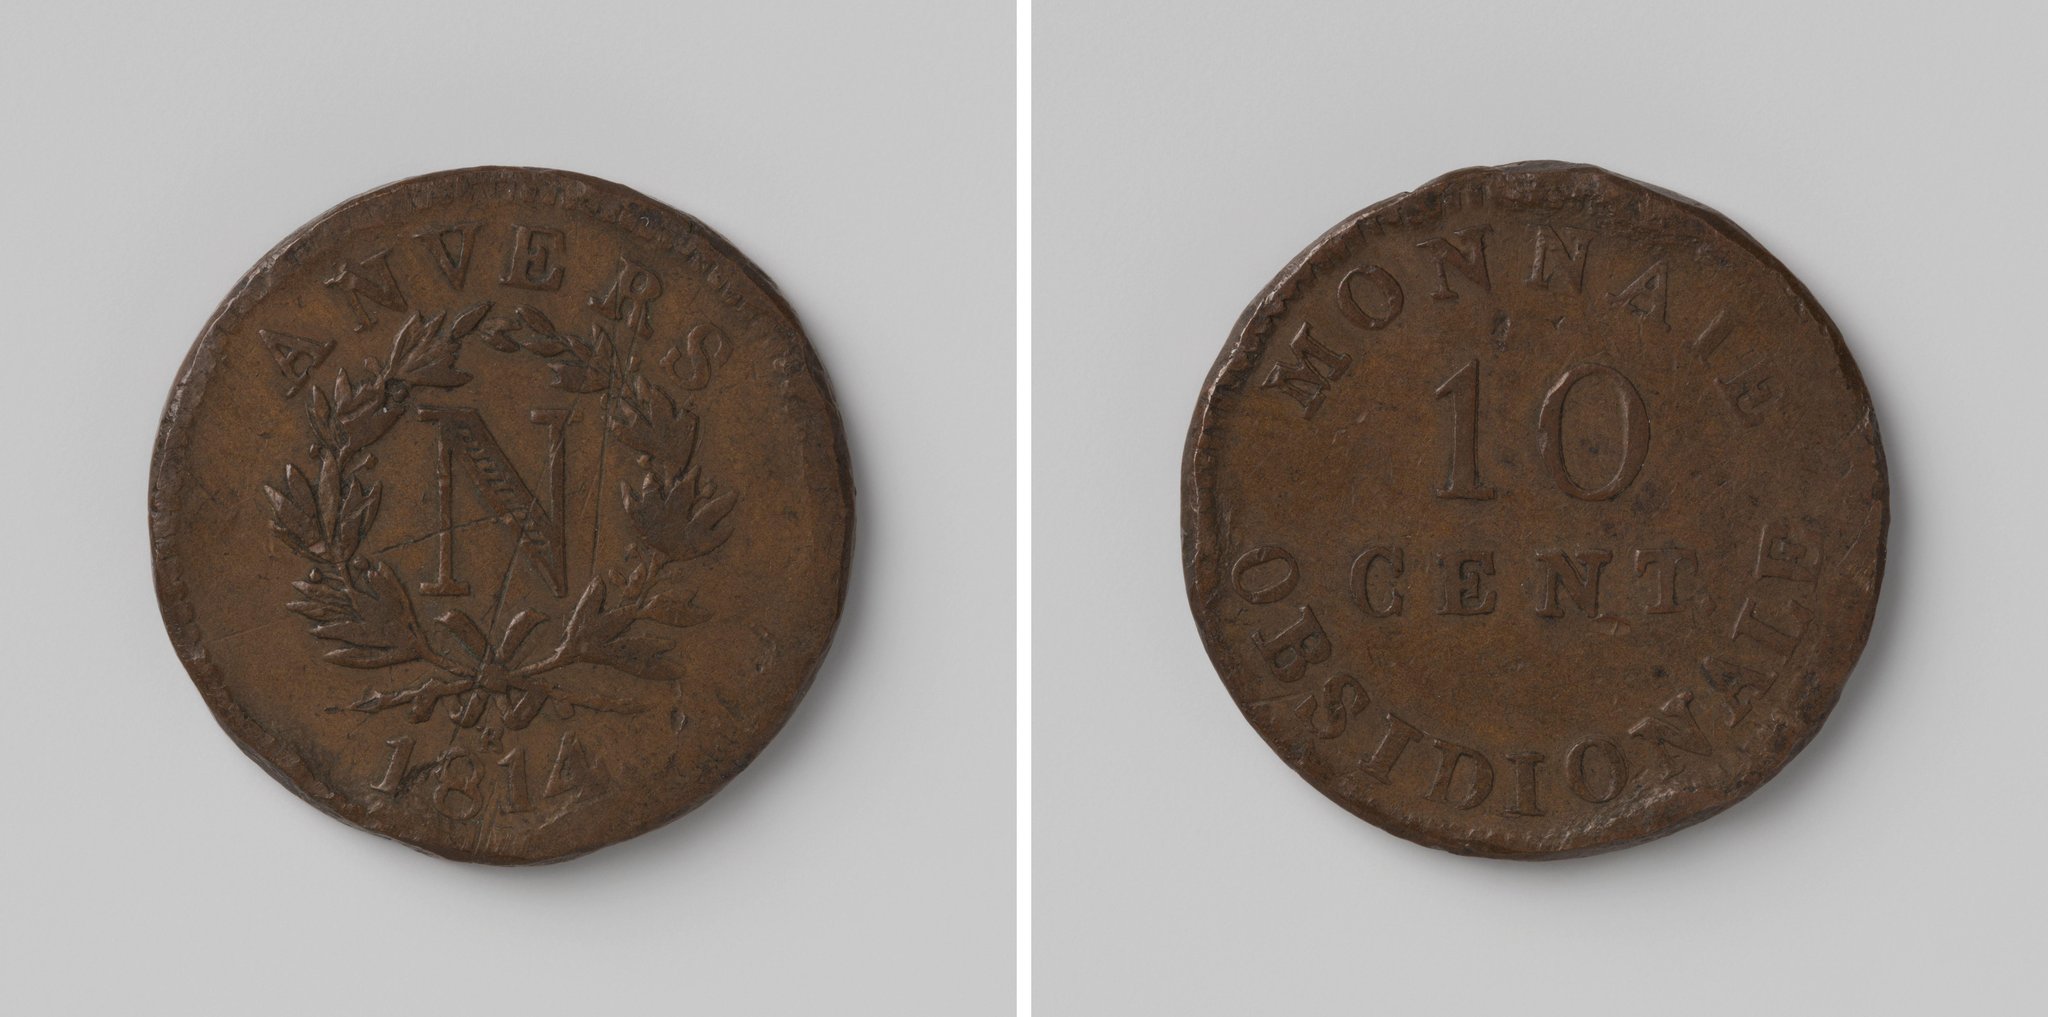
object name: siege coin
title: Beleg van Antwerpen, noodmunt van tien cent, geslagen door Napoleon I Bonaparte, keizer der Fransen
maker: Anonymous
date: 1814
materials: copper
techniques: striking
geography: antwerp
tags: napoleon i (emperor of the french), antwerp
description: Voorzijde: letter N binnen lauwerkrans onder opschrift boven jaartal; onder letter N: kleine letter W. Keerzijde: waardeaanduiding binnen omschrift